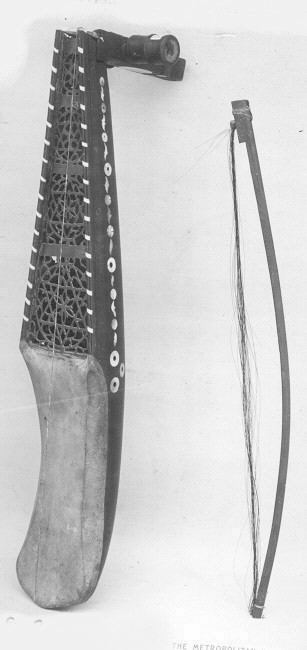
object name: rabāb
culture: algerian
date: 1801-1900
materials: bone, brass, leather, mother of pearl, wood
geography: algeria